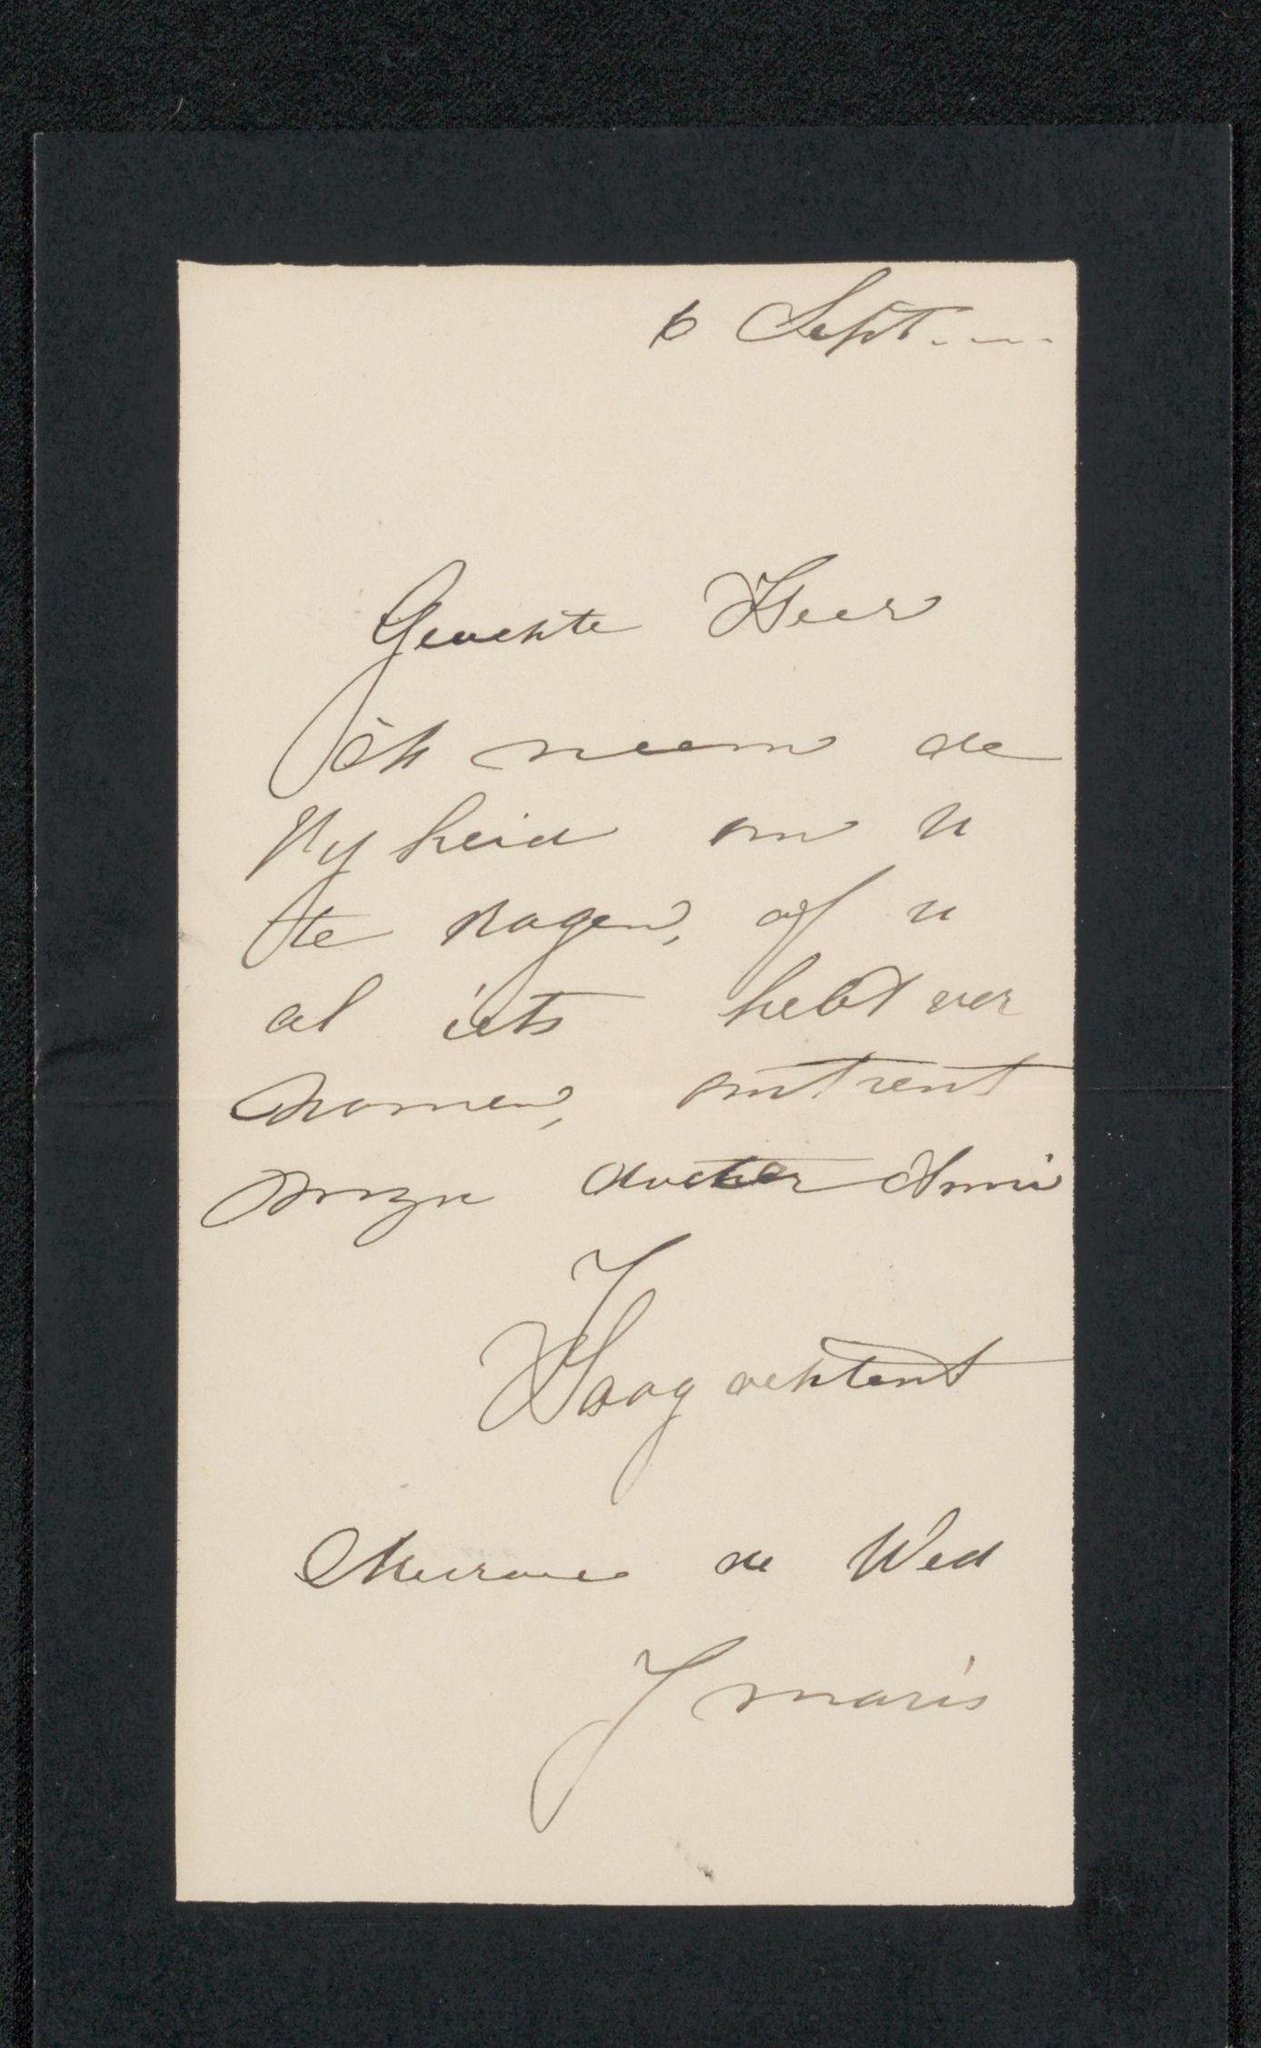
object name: letter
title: Brief aan Philip Zilcken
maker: catharina hendrika maris-horn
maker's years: 1841-1905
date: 1899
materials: ink, paper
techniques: pen, writing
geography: the hague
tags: the hague, amsterdam, annie maris, painter, philip zilcken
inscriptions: collector's mark: ‘RPK’